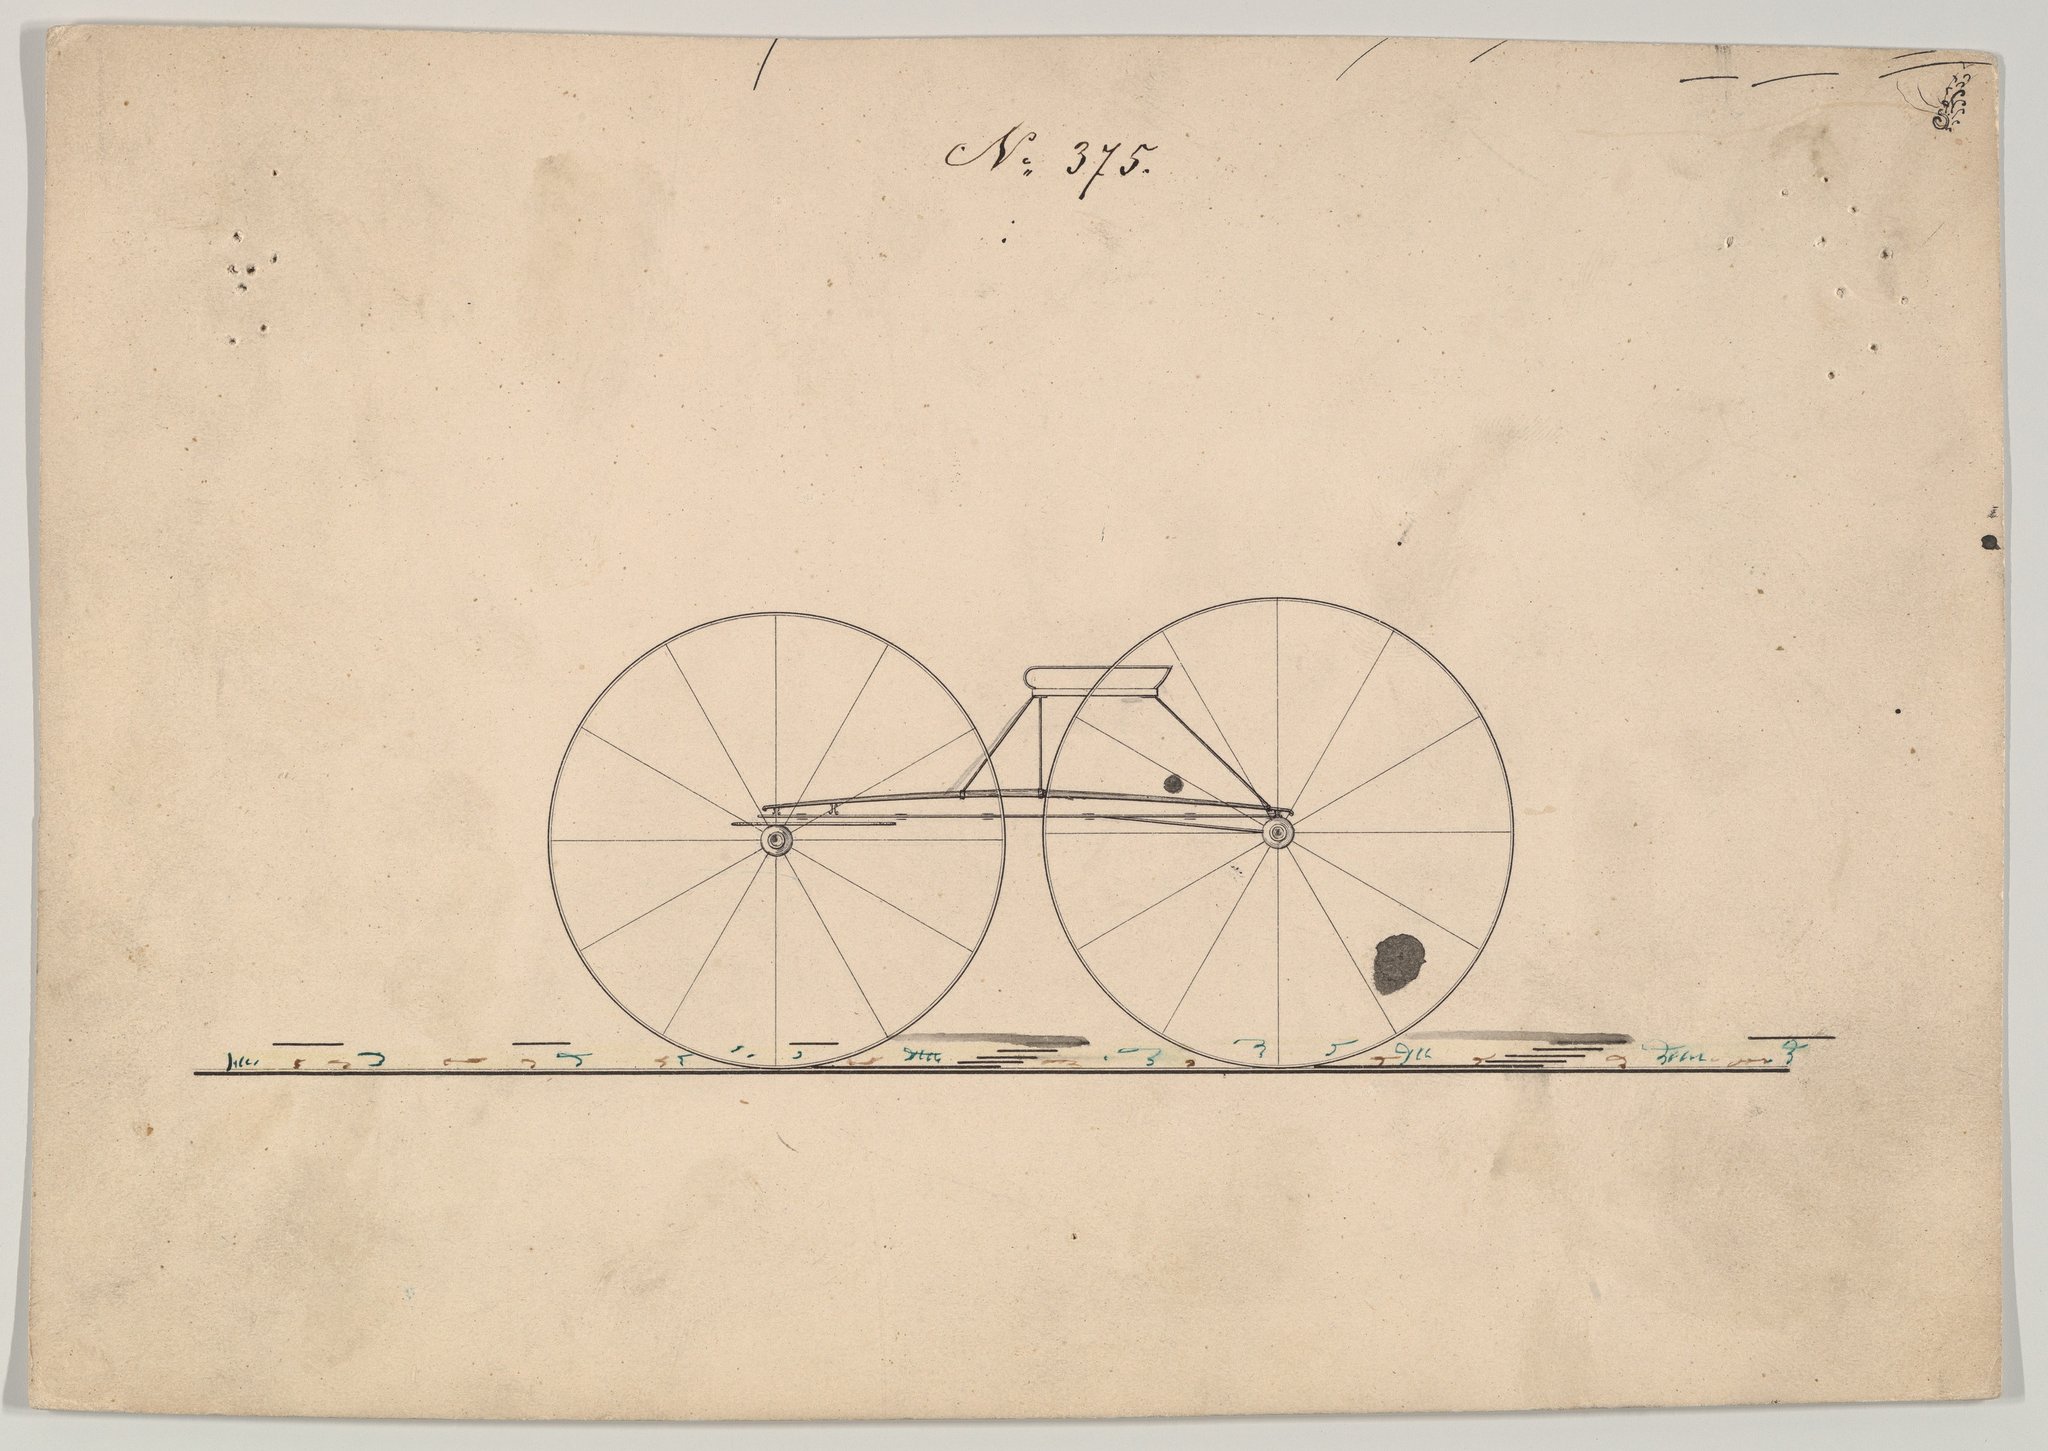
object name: drawing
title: Skeleton Wagon #375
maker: brewster & co.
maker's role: manufacturer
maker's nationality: american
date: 1865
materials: gouache, ink, watercolor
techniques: pen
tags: carriages